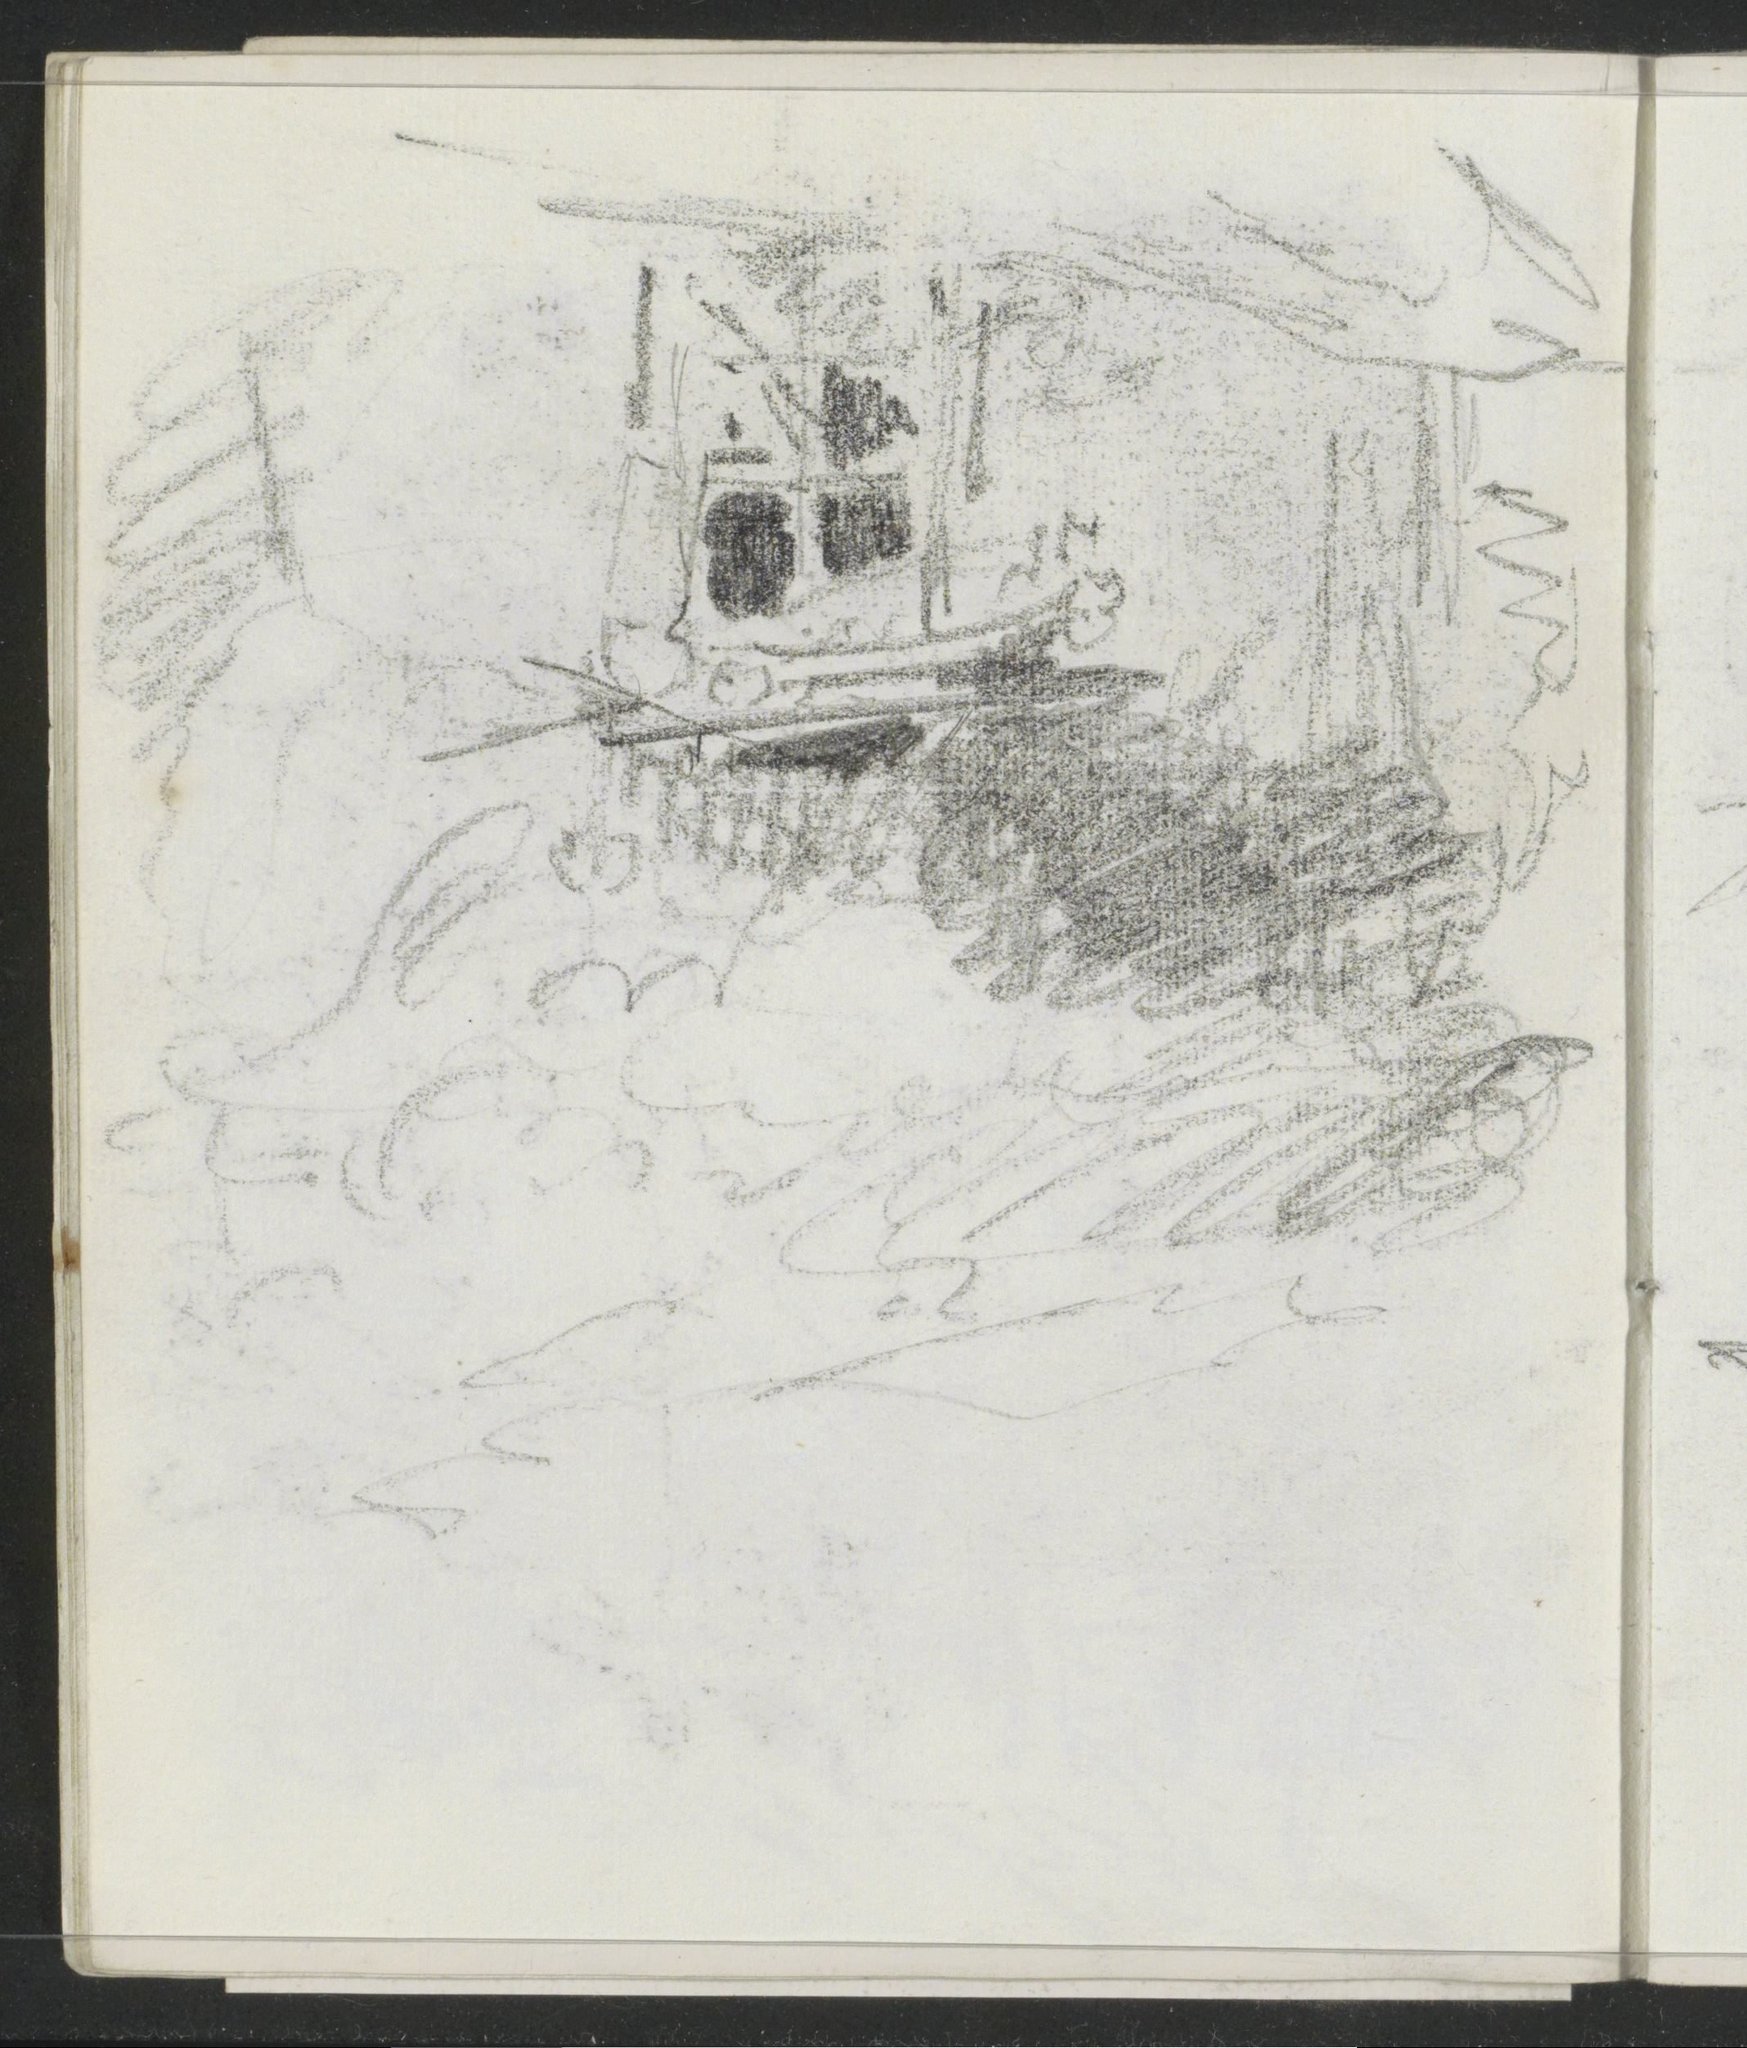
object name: sketchbook leaf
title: Raam met rasterwerk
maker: maria vos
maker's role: draughtsman, painter, print maker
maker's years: 1824-1906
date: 1834-1906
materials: paper, pencil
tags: window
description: Blad 6 verso uit een schetsboek met 20 bladen.